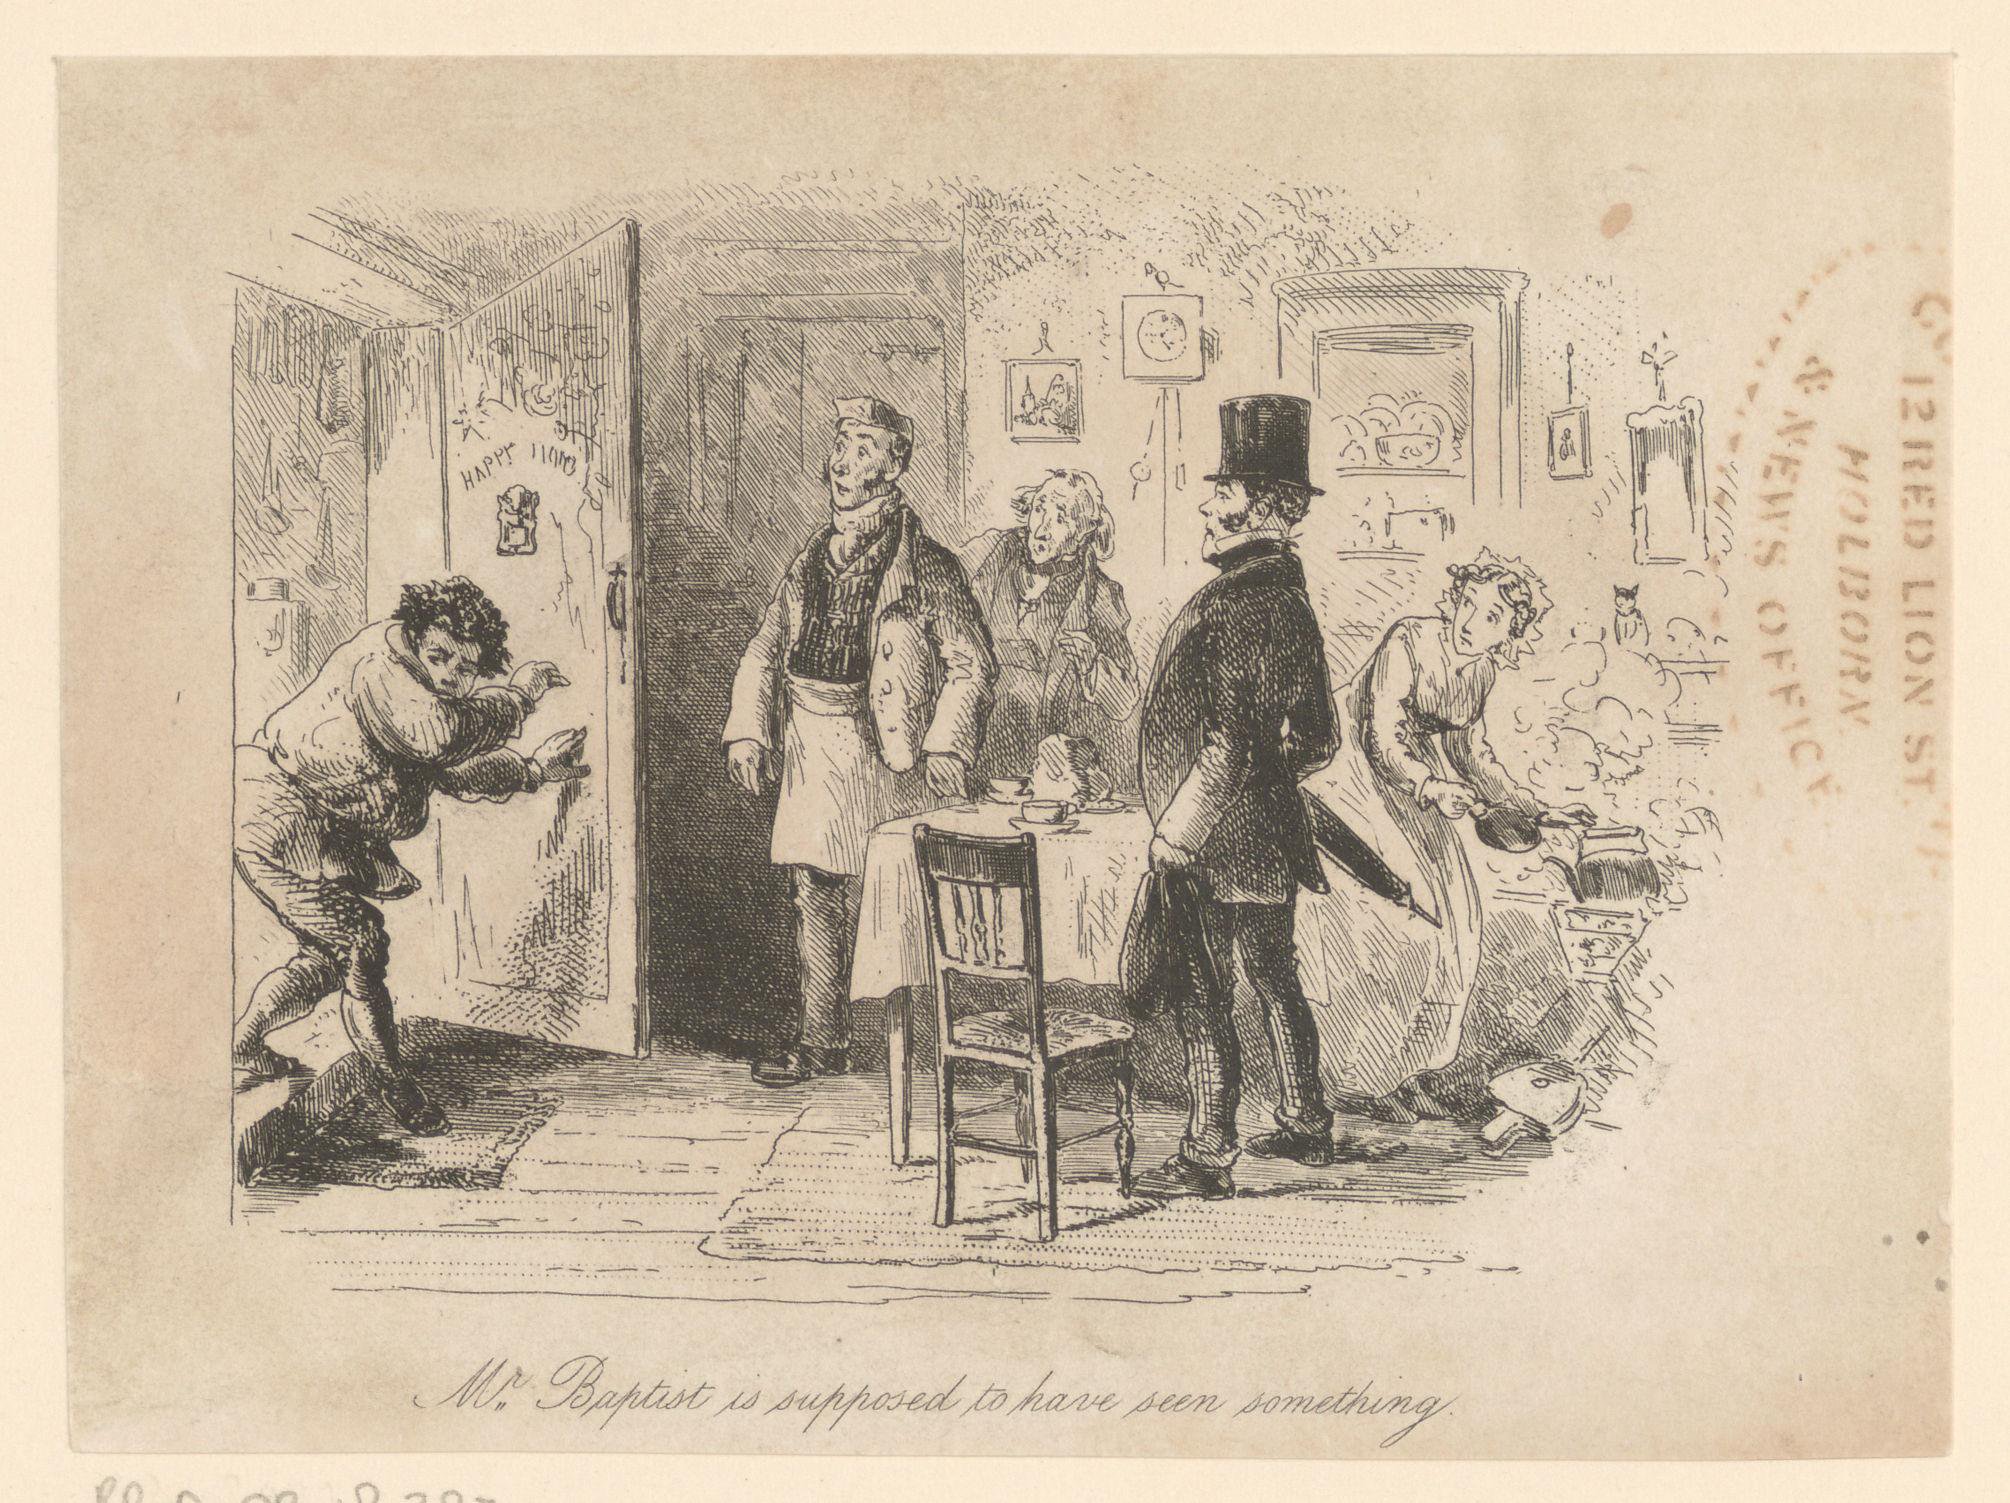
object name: book illustration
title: Mr. Baptist is supposed to have seen something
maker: hablot knight browne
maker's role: print maker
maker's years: 1815-1882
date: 1857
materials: paper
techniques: etching, roulette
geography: london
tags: leaning forward, surprise, wonder; 'maraviglia' (ripa)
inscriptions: collector's mark: Lugt 2228, stamp: ‘12 Red Lion St. Holborn & News Office’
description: Prent uit: Dickens, Charles. Little Dorrit. Londen: Bradbury & Evans, 1857.